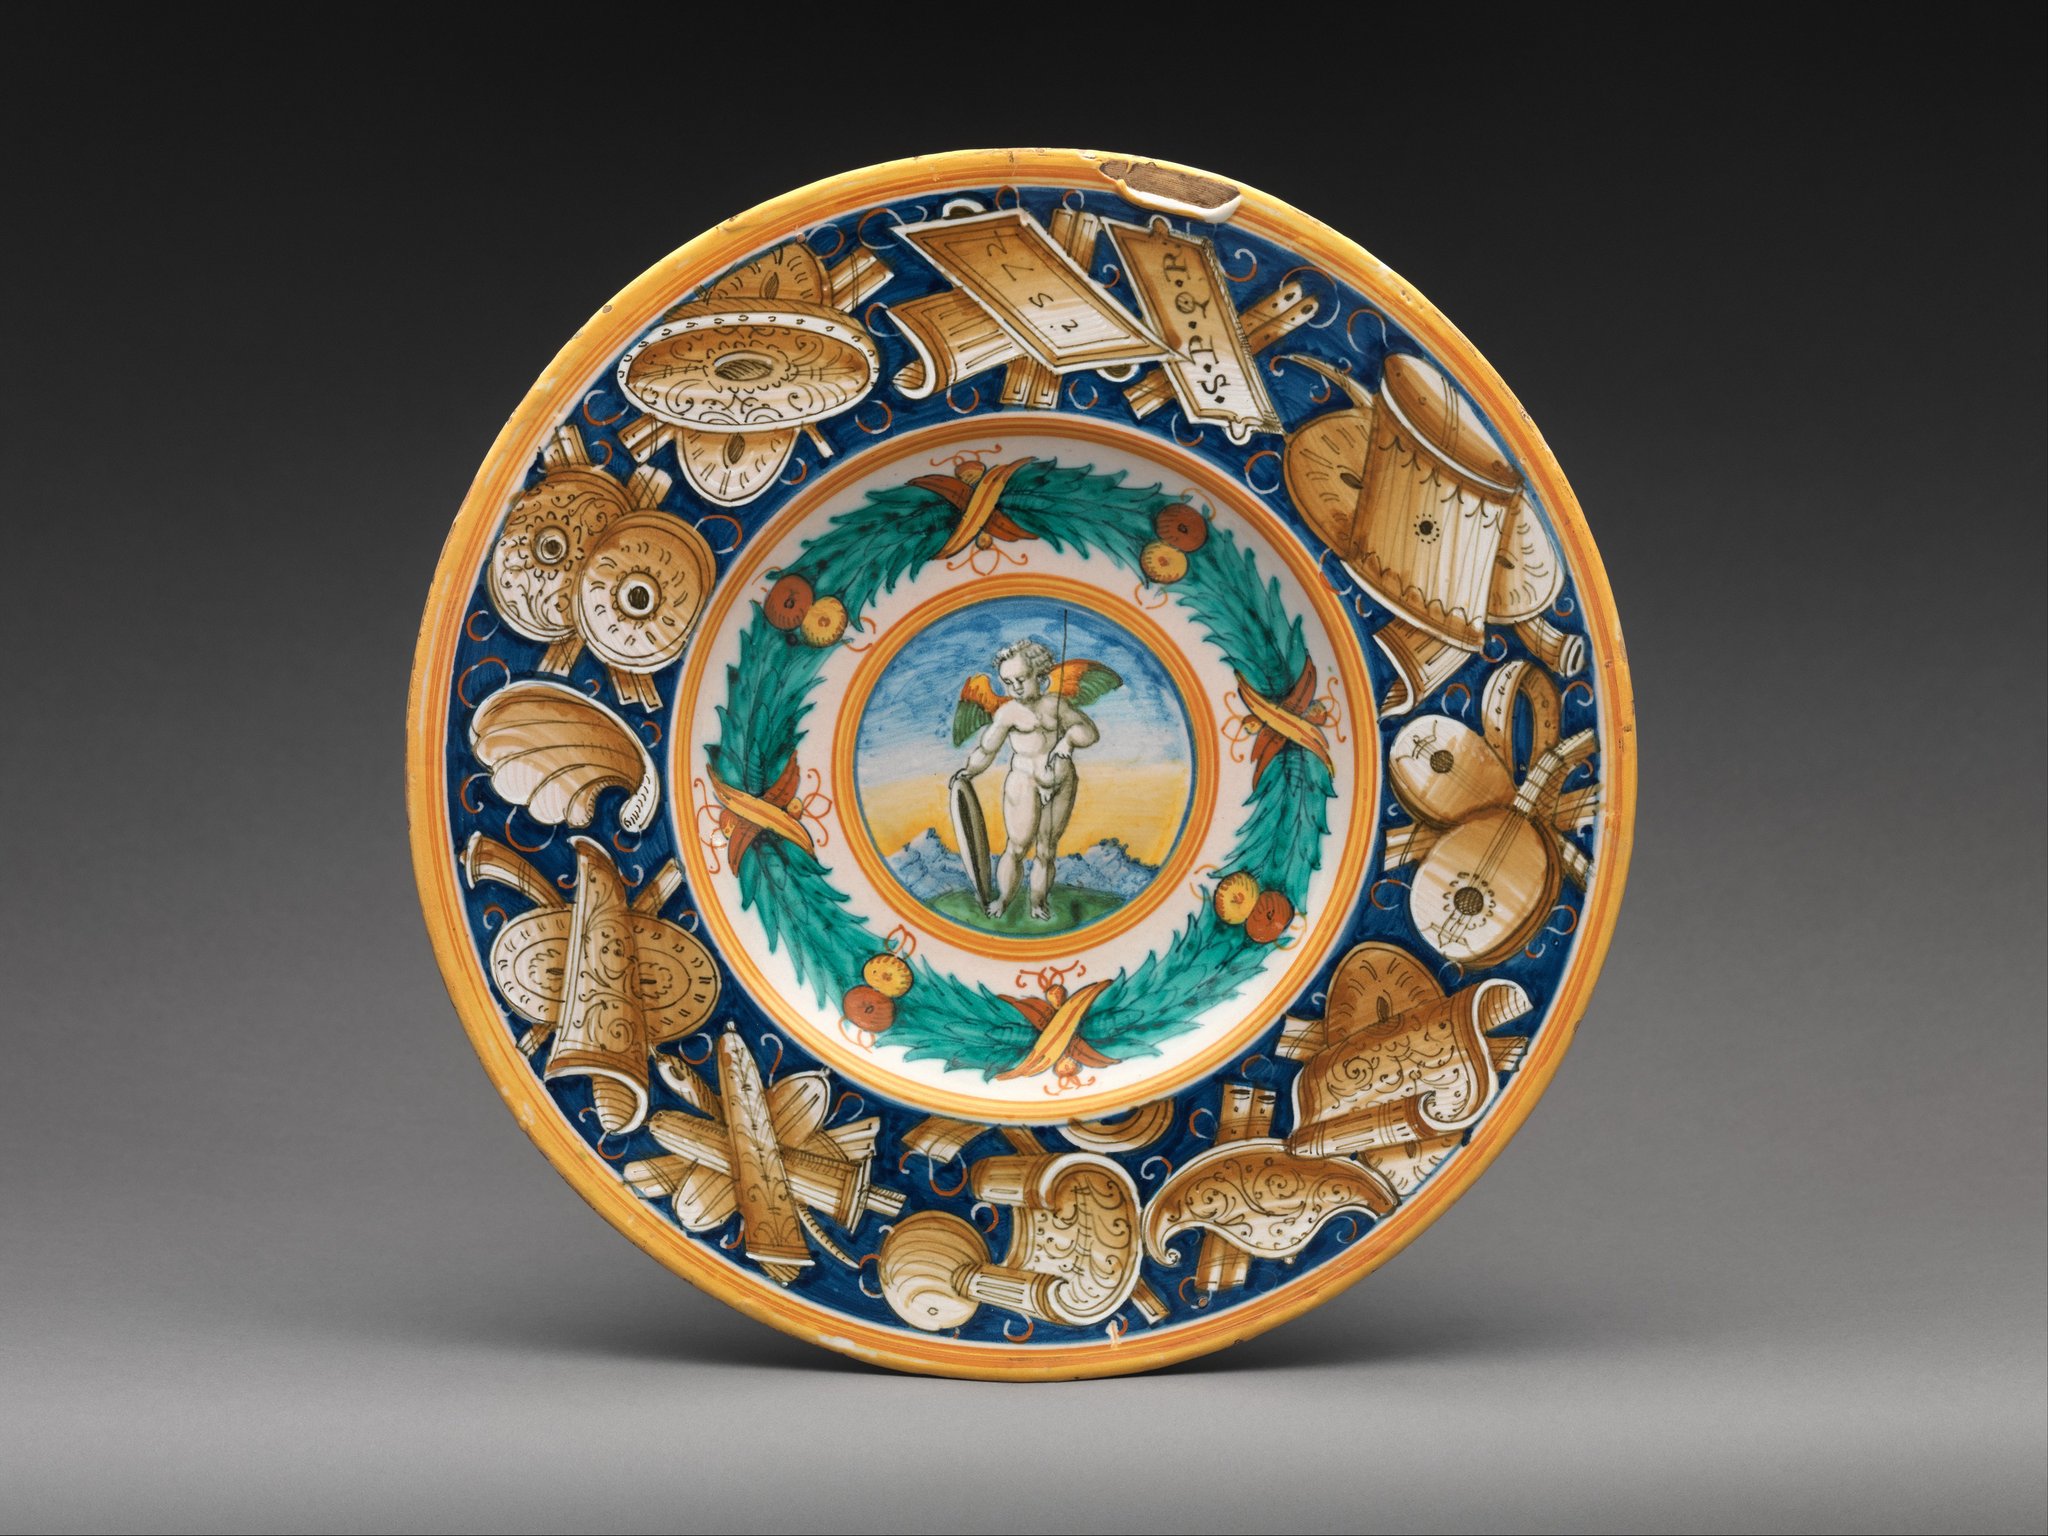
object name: dish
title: Dish with winged putto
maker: cipriano piccolpasso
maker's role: designer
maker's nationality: italian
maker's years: 1530-1565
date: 1572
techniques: maiolica, glazing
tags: musical instruments,putti,wreaths